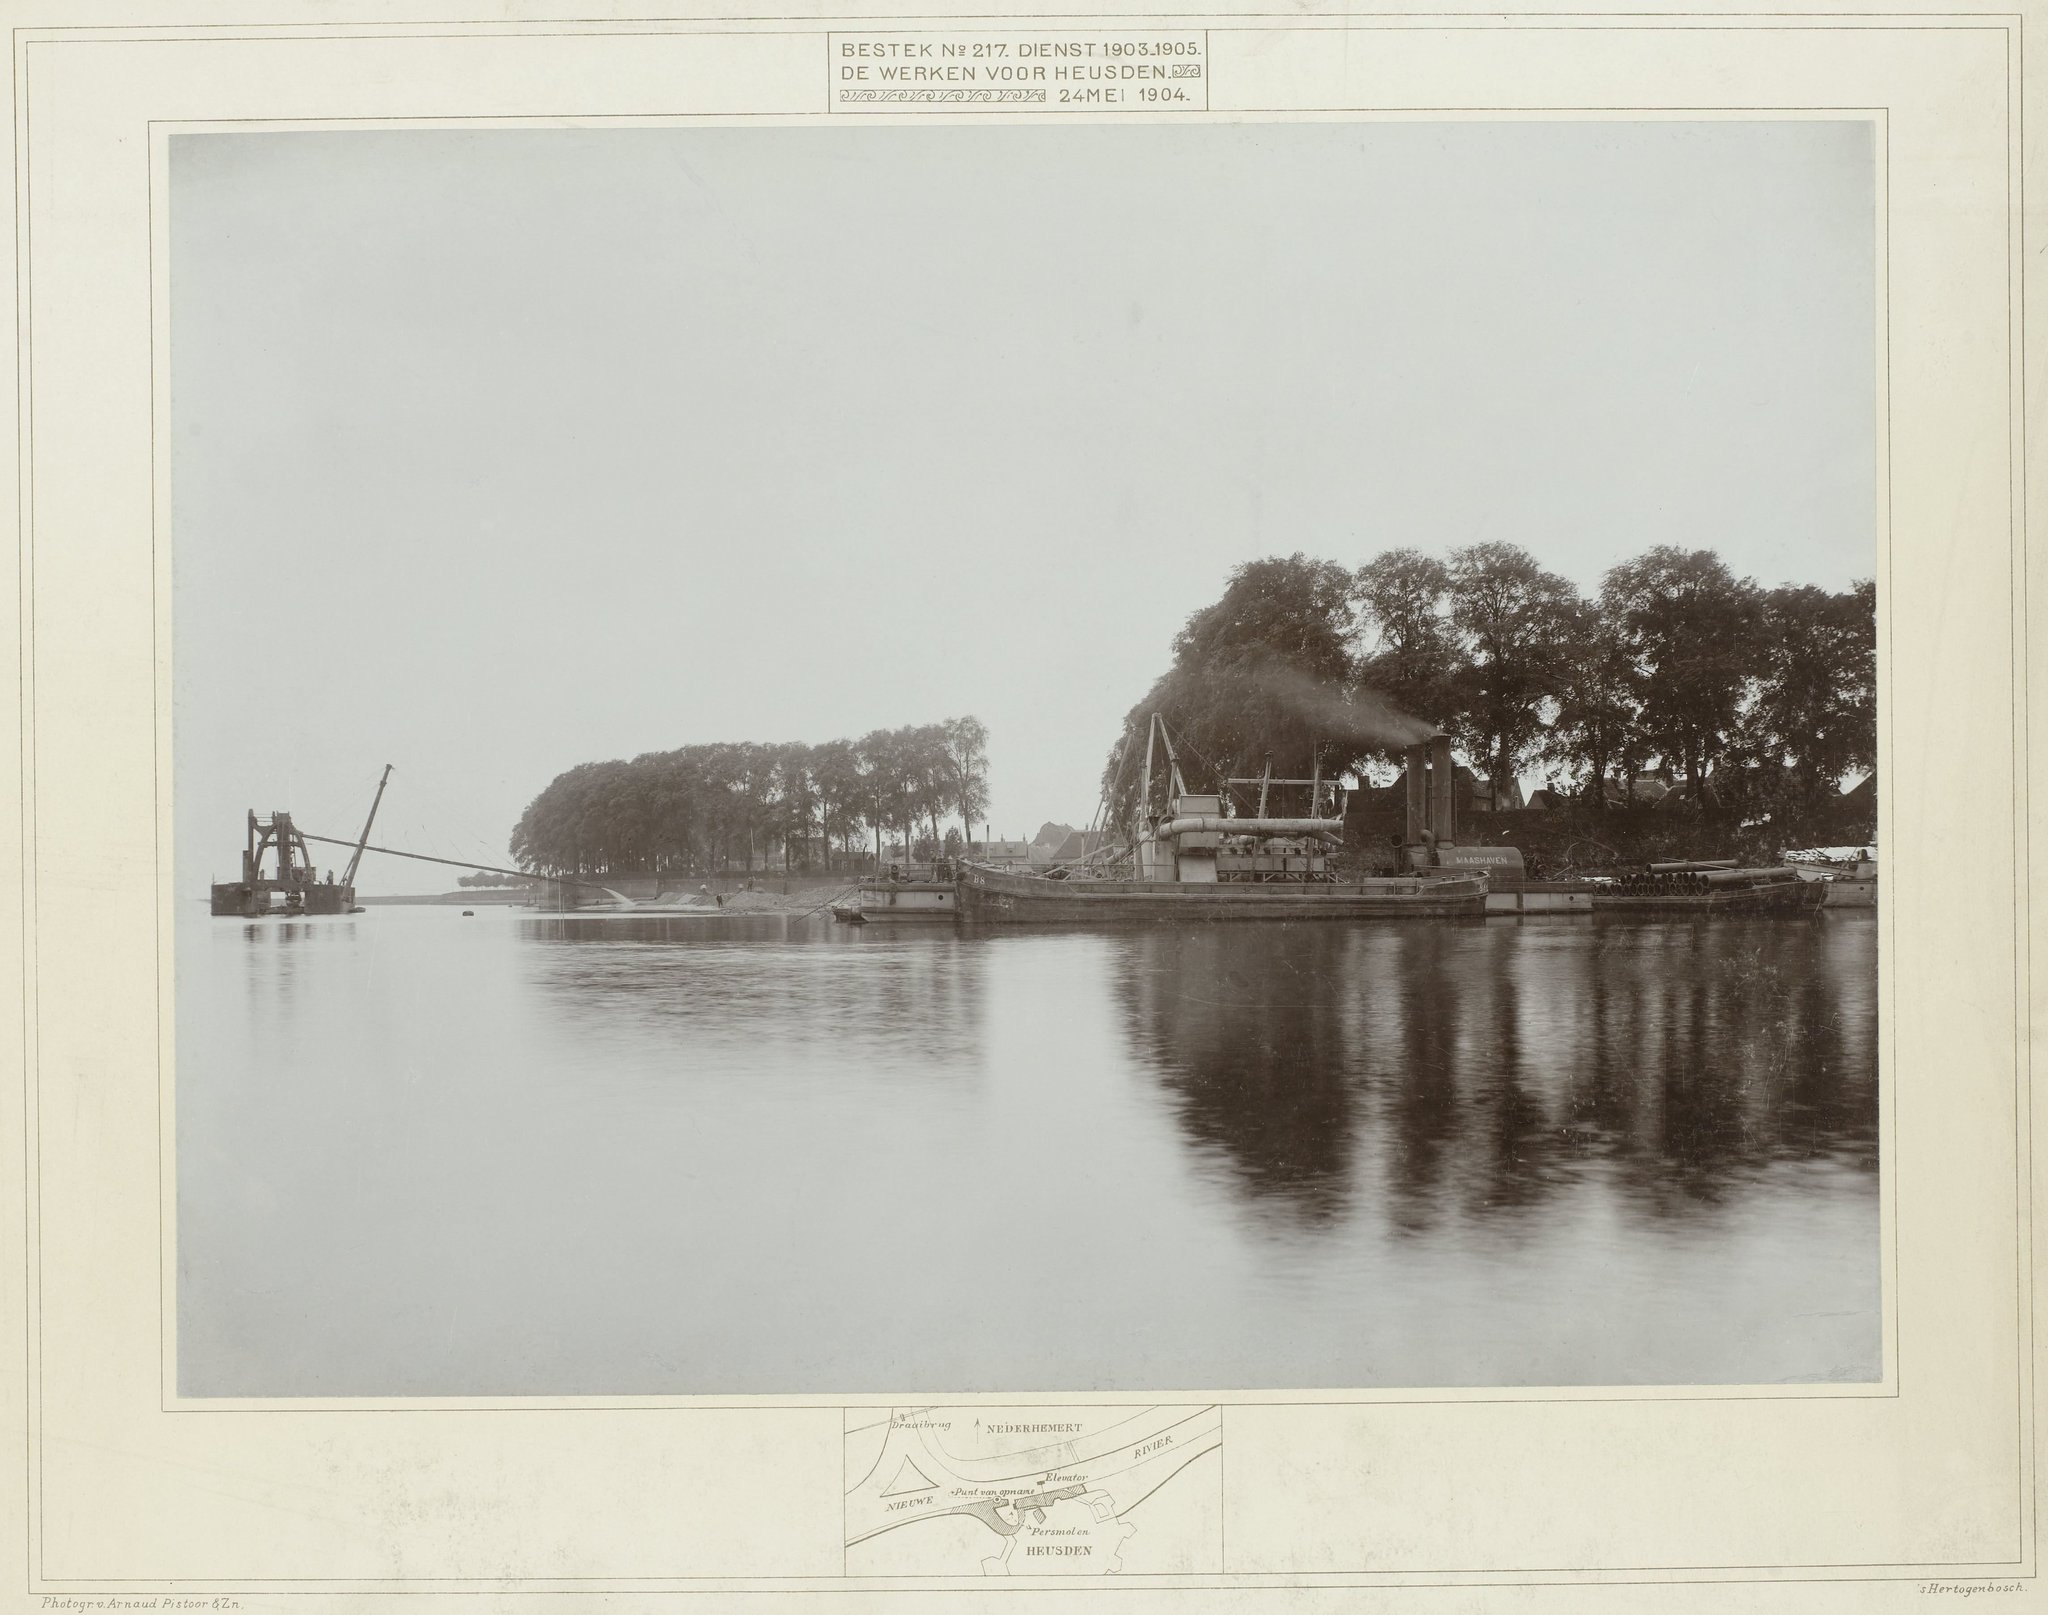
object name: photograph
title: Bestek nr. 217, dienst 1903, 1905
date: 1904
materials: cardboard, paper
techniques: photography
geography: den bosch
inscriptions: date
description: Foto op karton, van waterbouwkundige werken (ten behoeve van de scheiding tussen maas en waal. Tekst boven de foto, onder de foto een situatiekaartje. Gesigneerd en gedateerd. Opschrift: 'De werken voor Heusden 24 mei 1904.